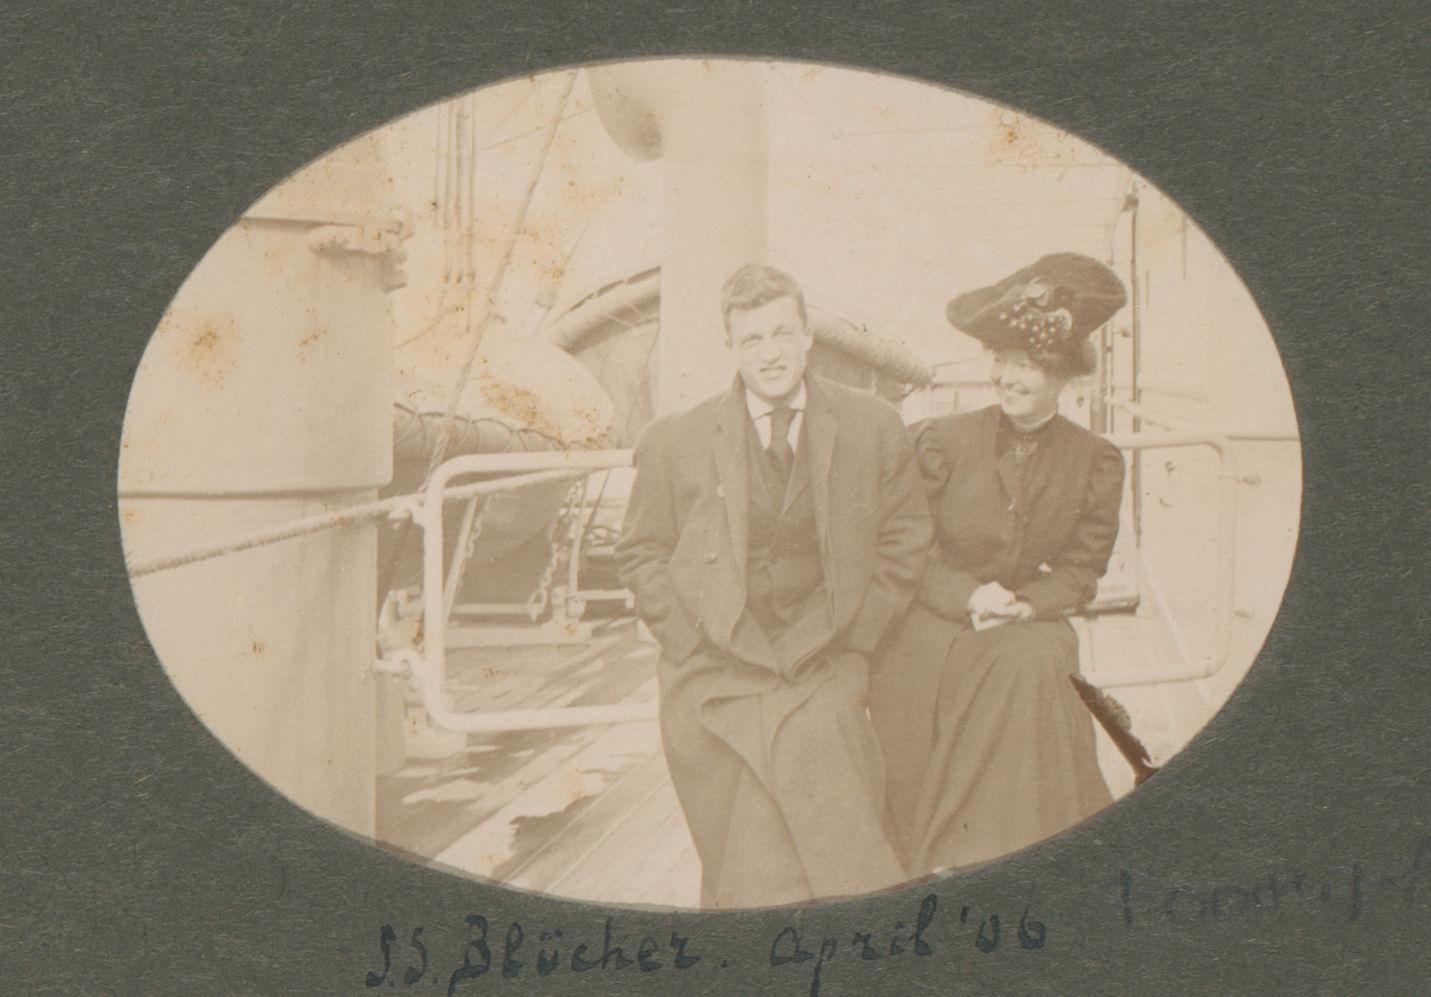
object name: album leaf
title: Man en een vrouw aan boord van SS Blücher, vermoedelijk tussen Hamburg en New York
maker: Anonymous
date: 1904-1906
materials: cardboard, paper, photographic support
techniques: gelatin silver print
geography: atlantic ocean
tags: passenger liner, atlantic ocean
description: Onderdeel van Reisalbum van een Nederlandse familie met bezienswaardigheden in Europa, Egypte en New York.